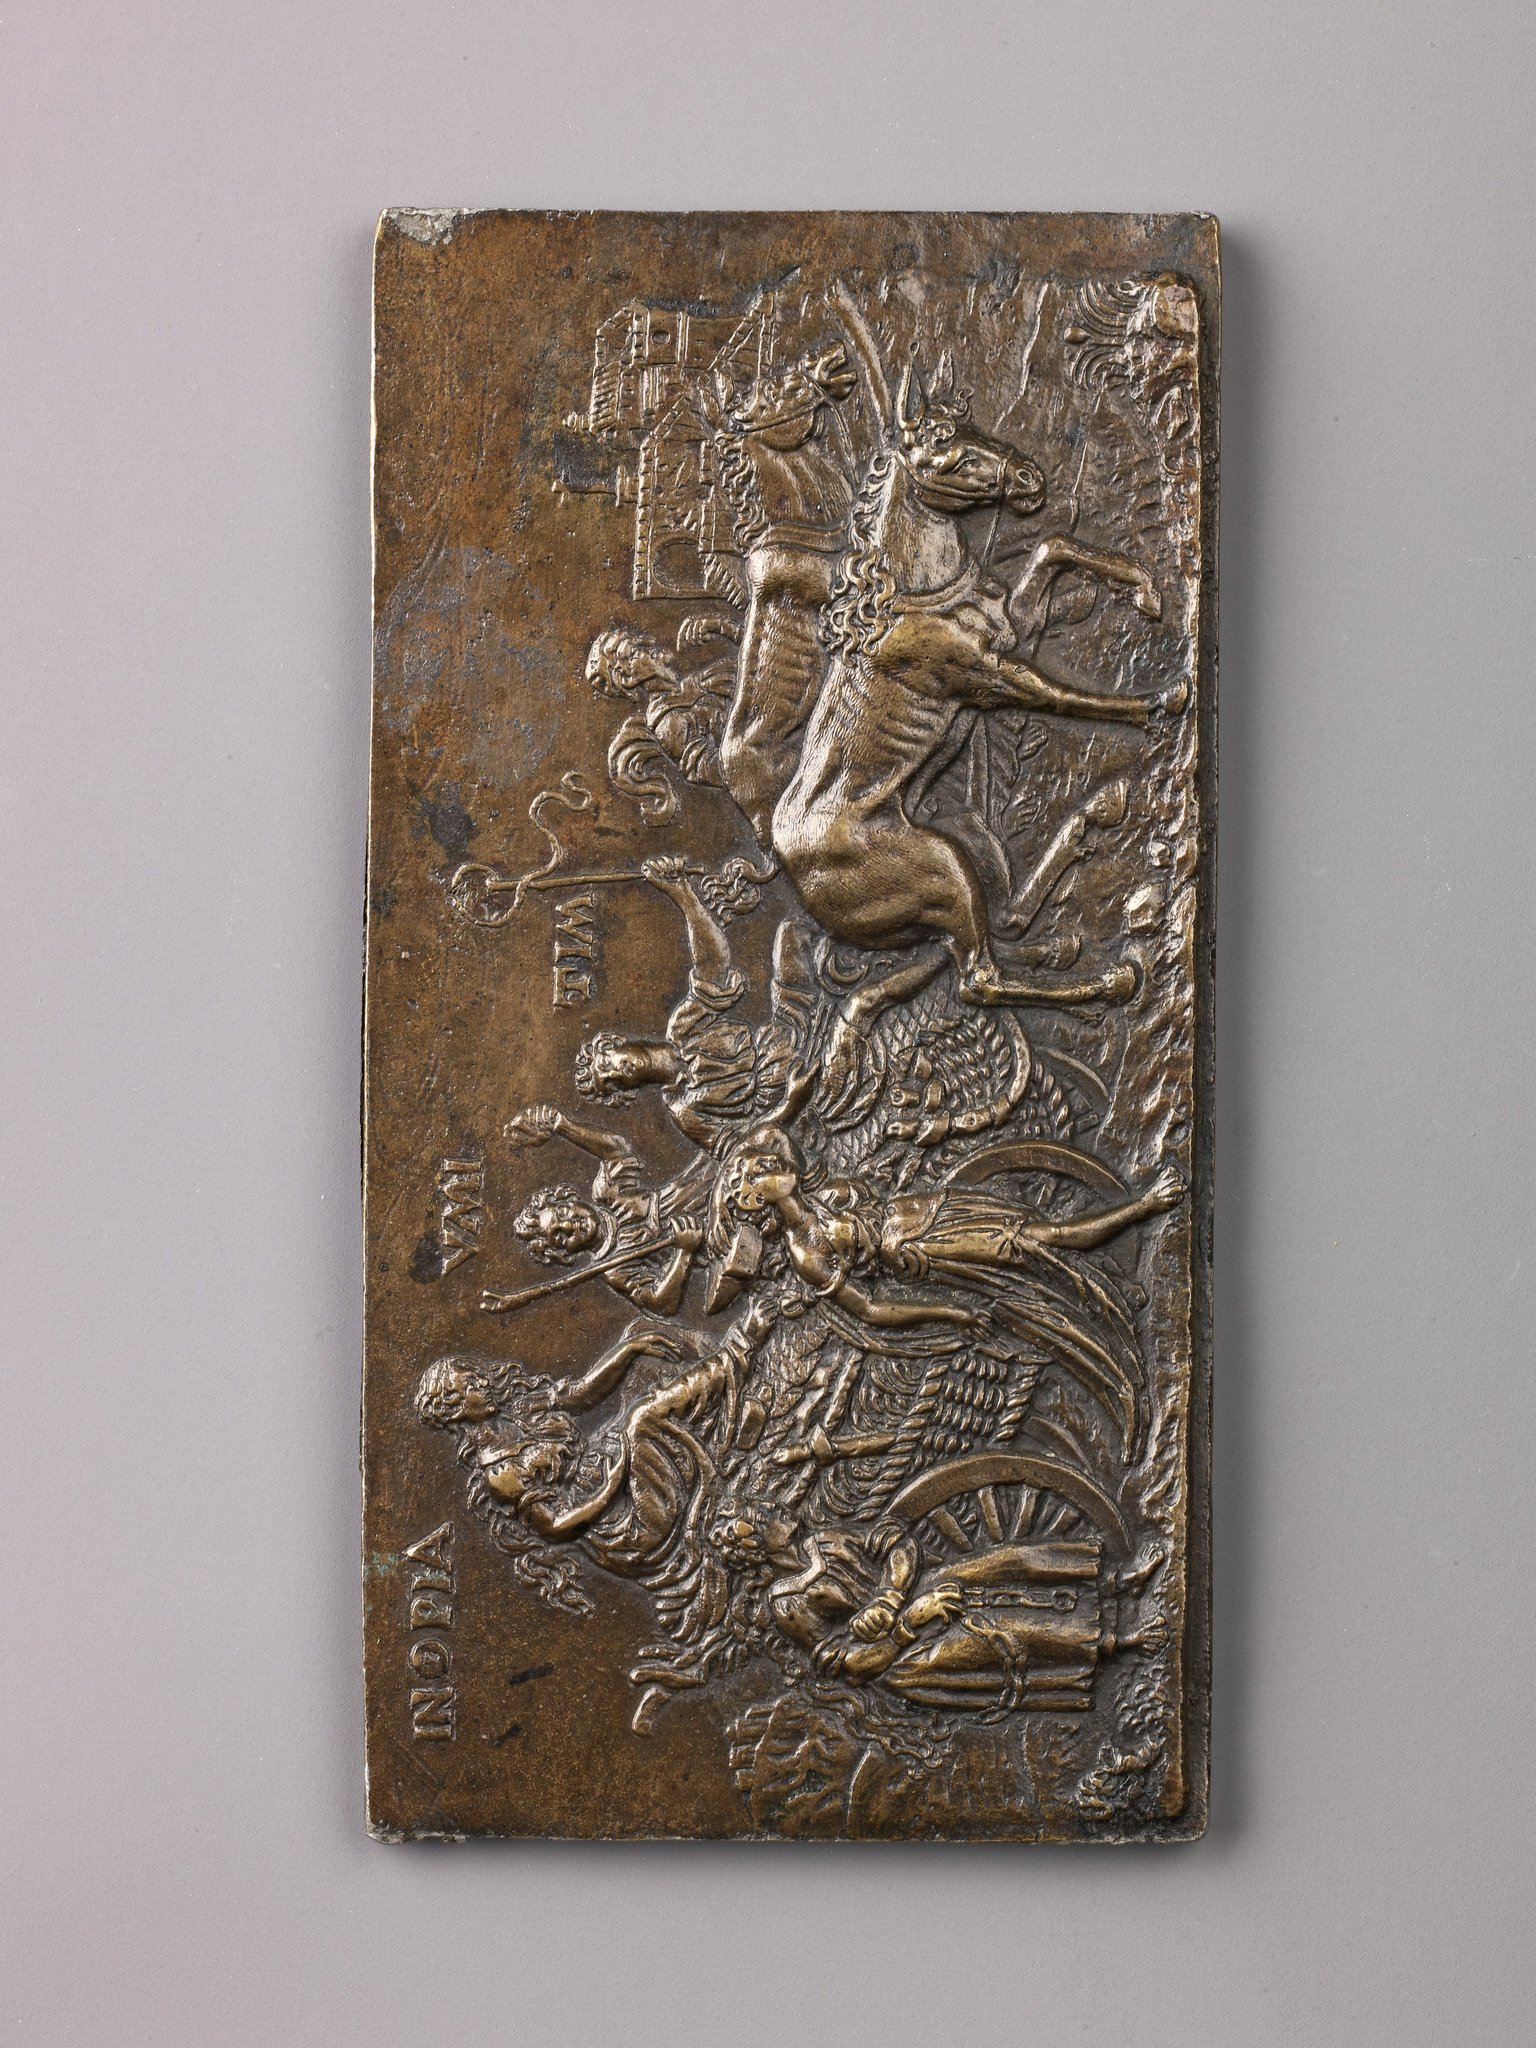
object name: plaquette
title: Allegory of the Triumph of Poverty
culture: south netherlandish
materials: copper alloy, patina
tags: men,women,horses,carts